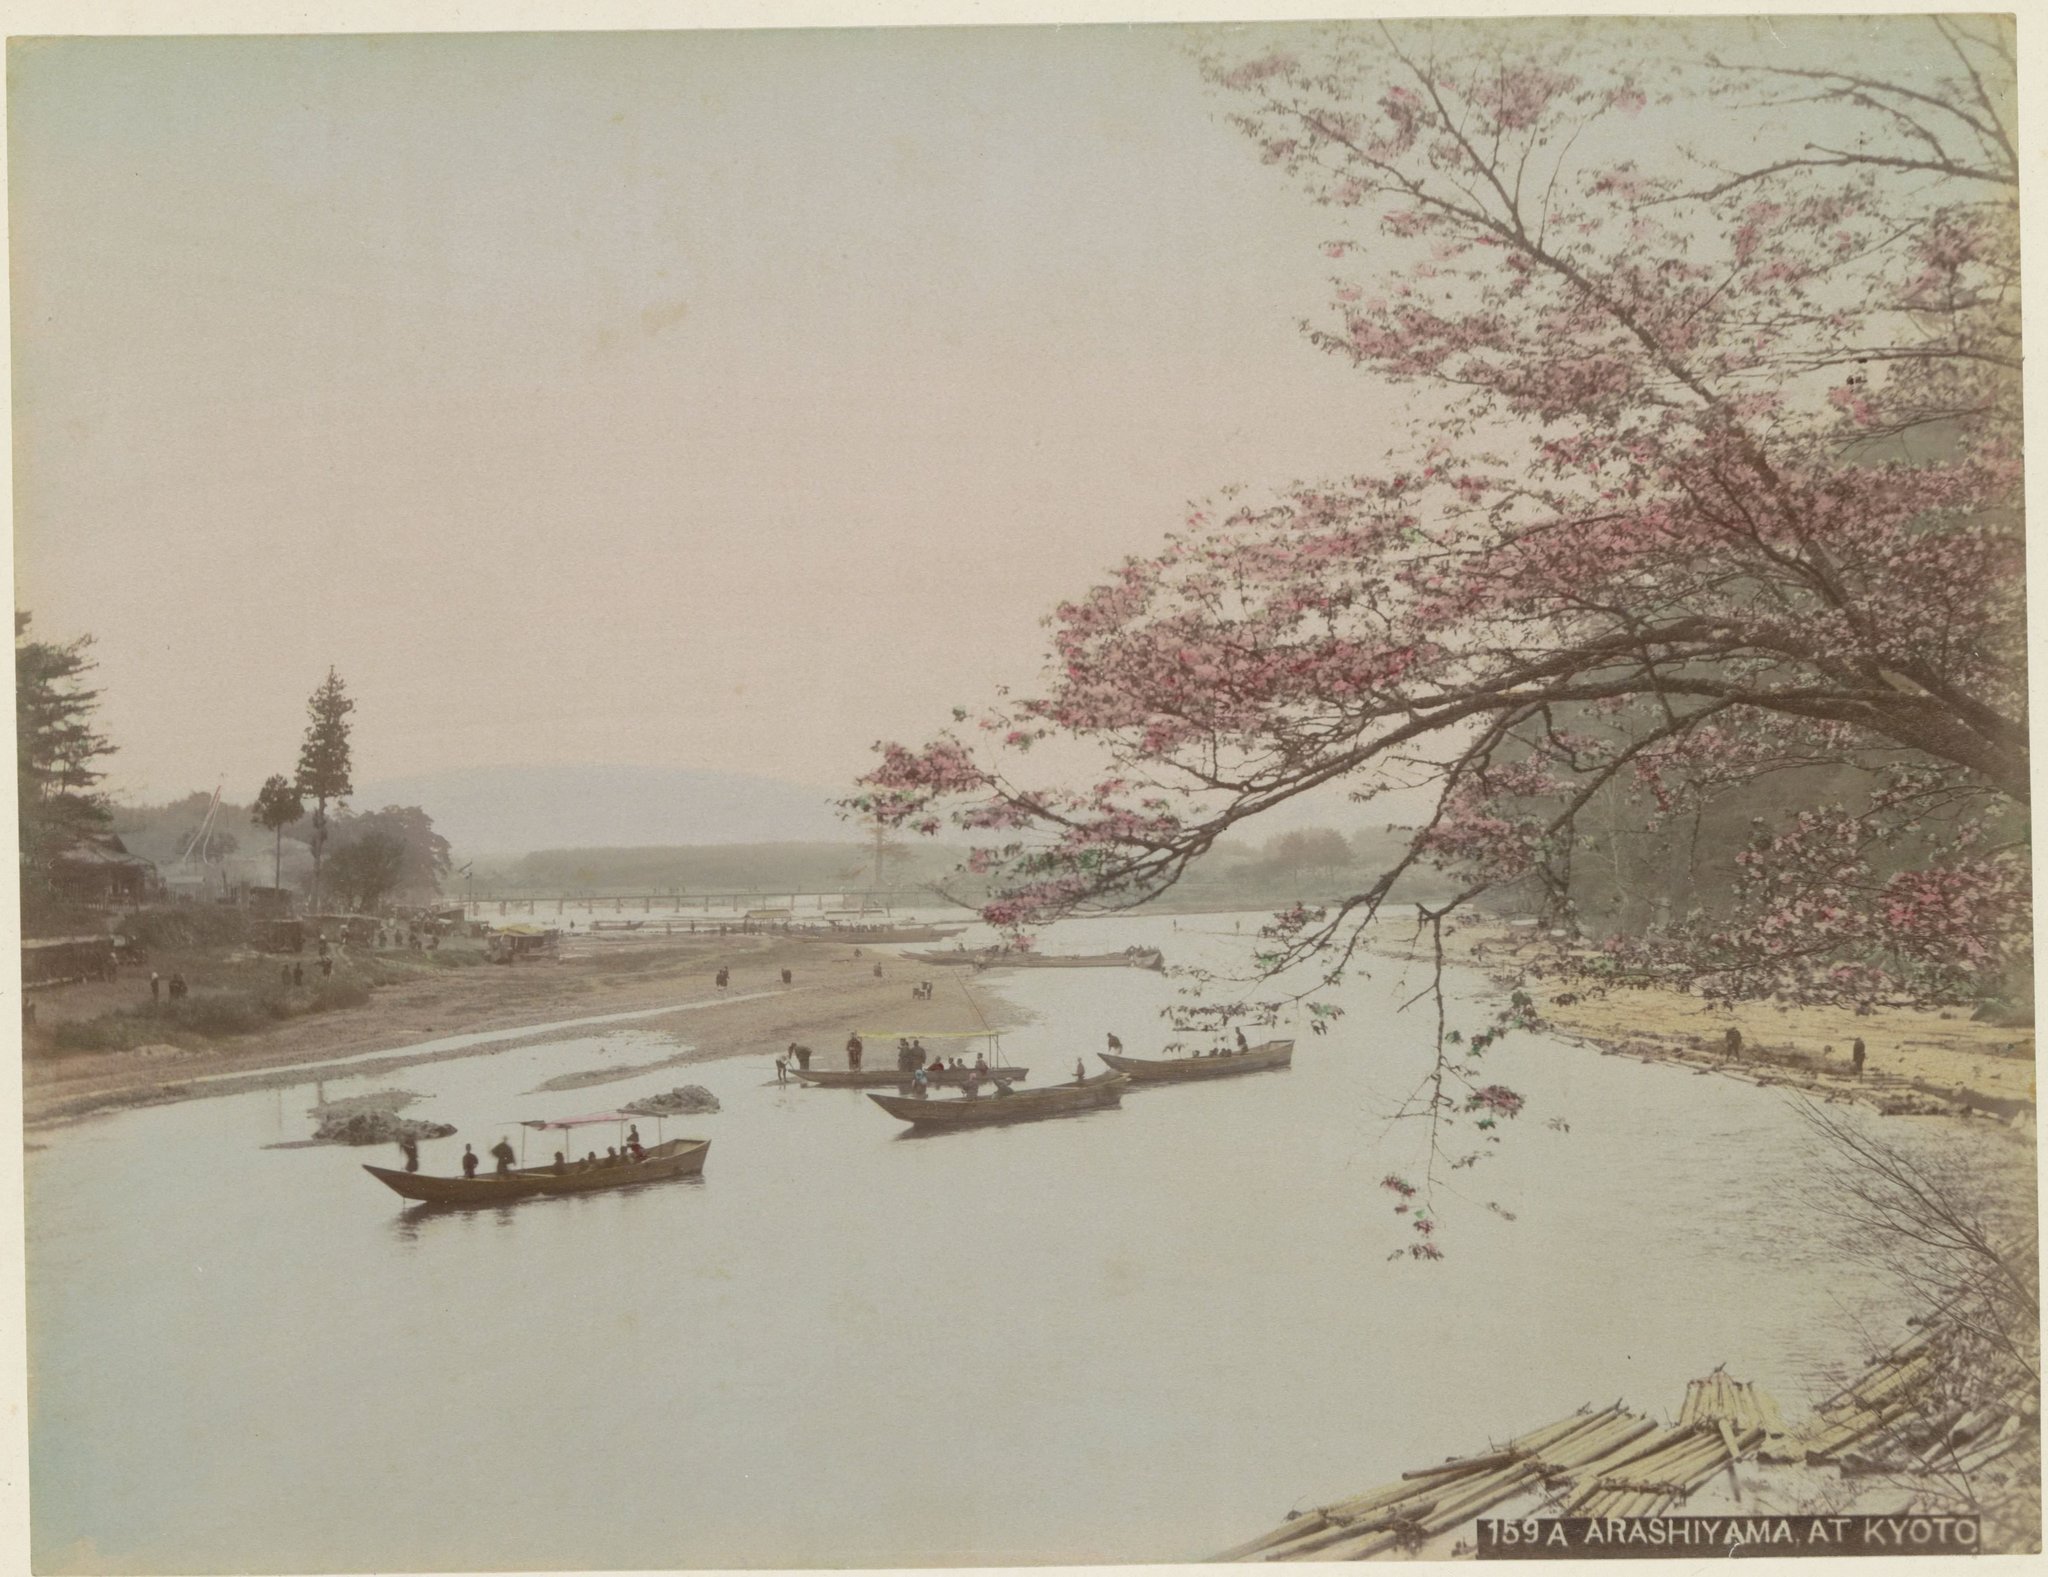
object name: photograph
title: Gezicht op een rivier met drijvende boomstammen en boten in Arashiyama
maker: Anonymous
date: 1870-1900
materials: cardboard, paper, photographic support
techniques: albumen print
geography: kyoto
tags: timber floating down the river, river (+ landscape with figures, staffage), kyoto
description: Onderdeel van Reisalbum met foto's van bezienswaardigheden in Japan.